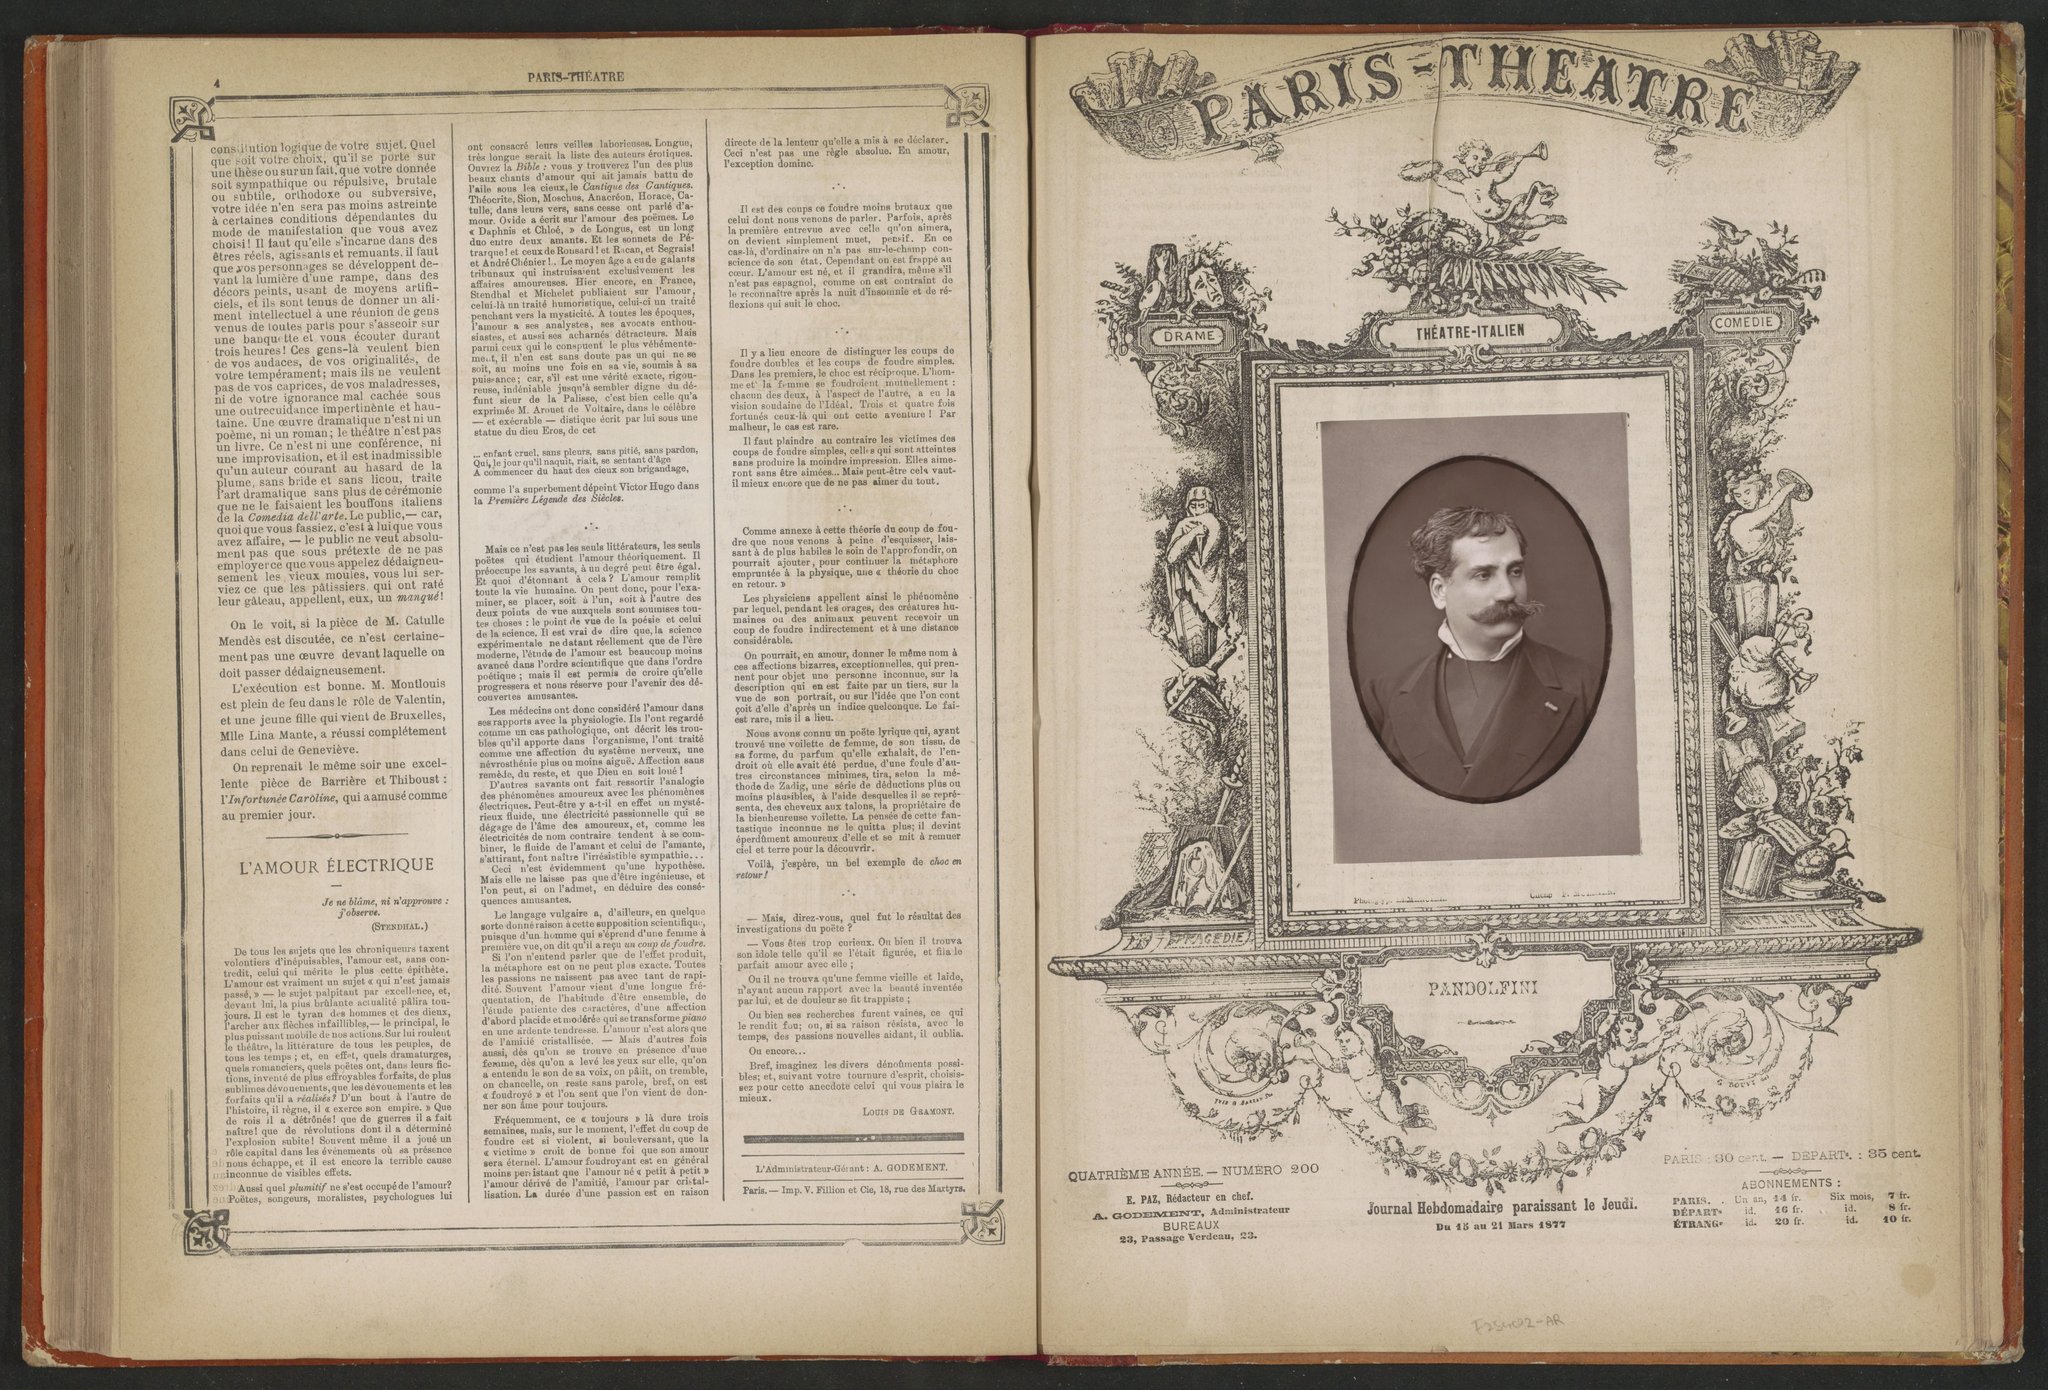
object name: page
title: Portret van Francesco Pandolfini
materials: paper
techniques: woodburytype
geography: france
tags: portrait of opera-singer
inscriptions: number: ‘Numéro 200’, inscription: ‘Journal Hebdomadaire paraissant le Jeudi, Du 15 au 21 Mars 1877’